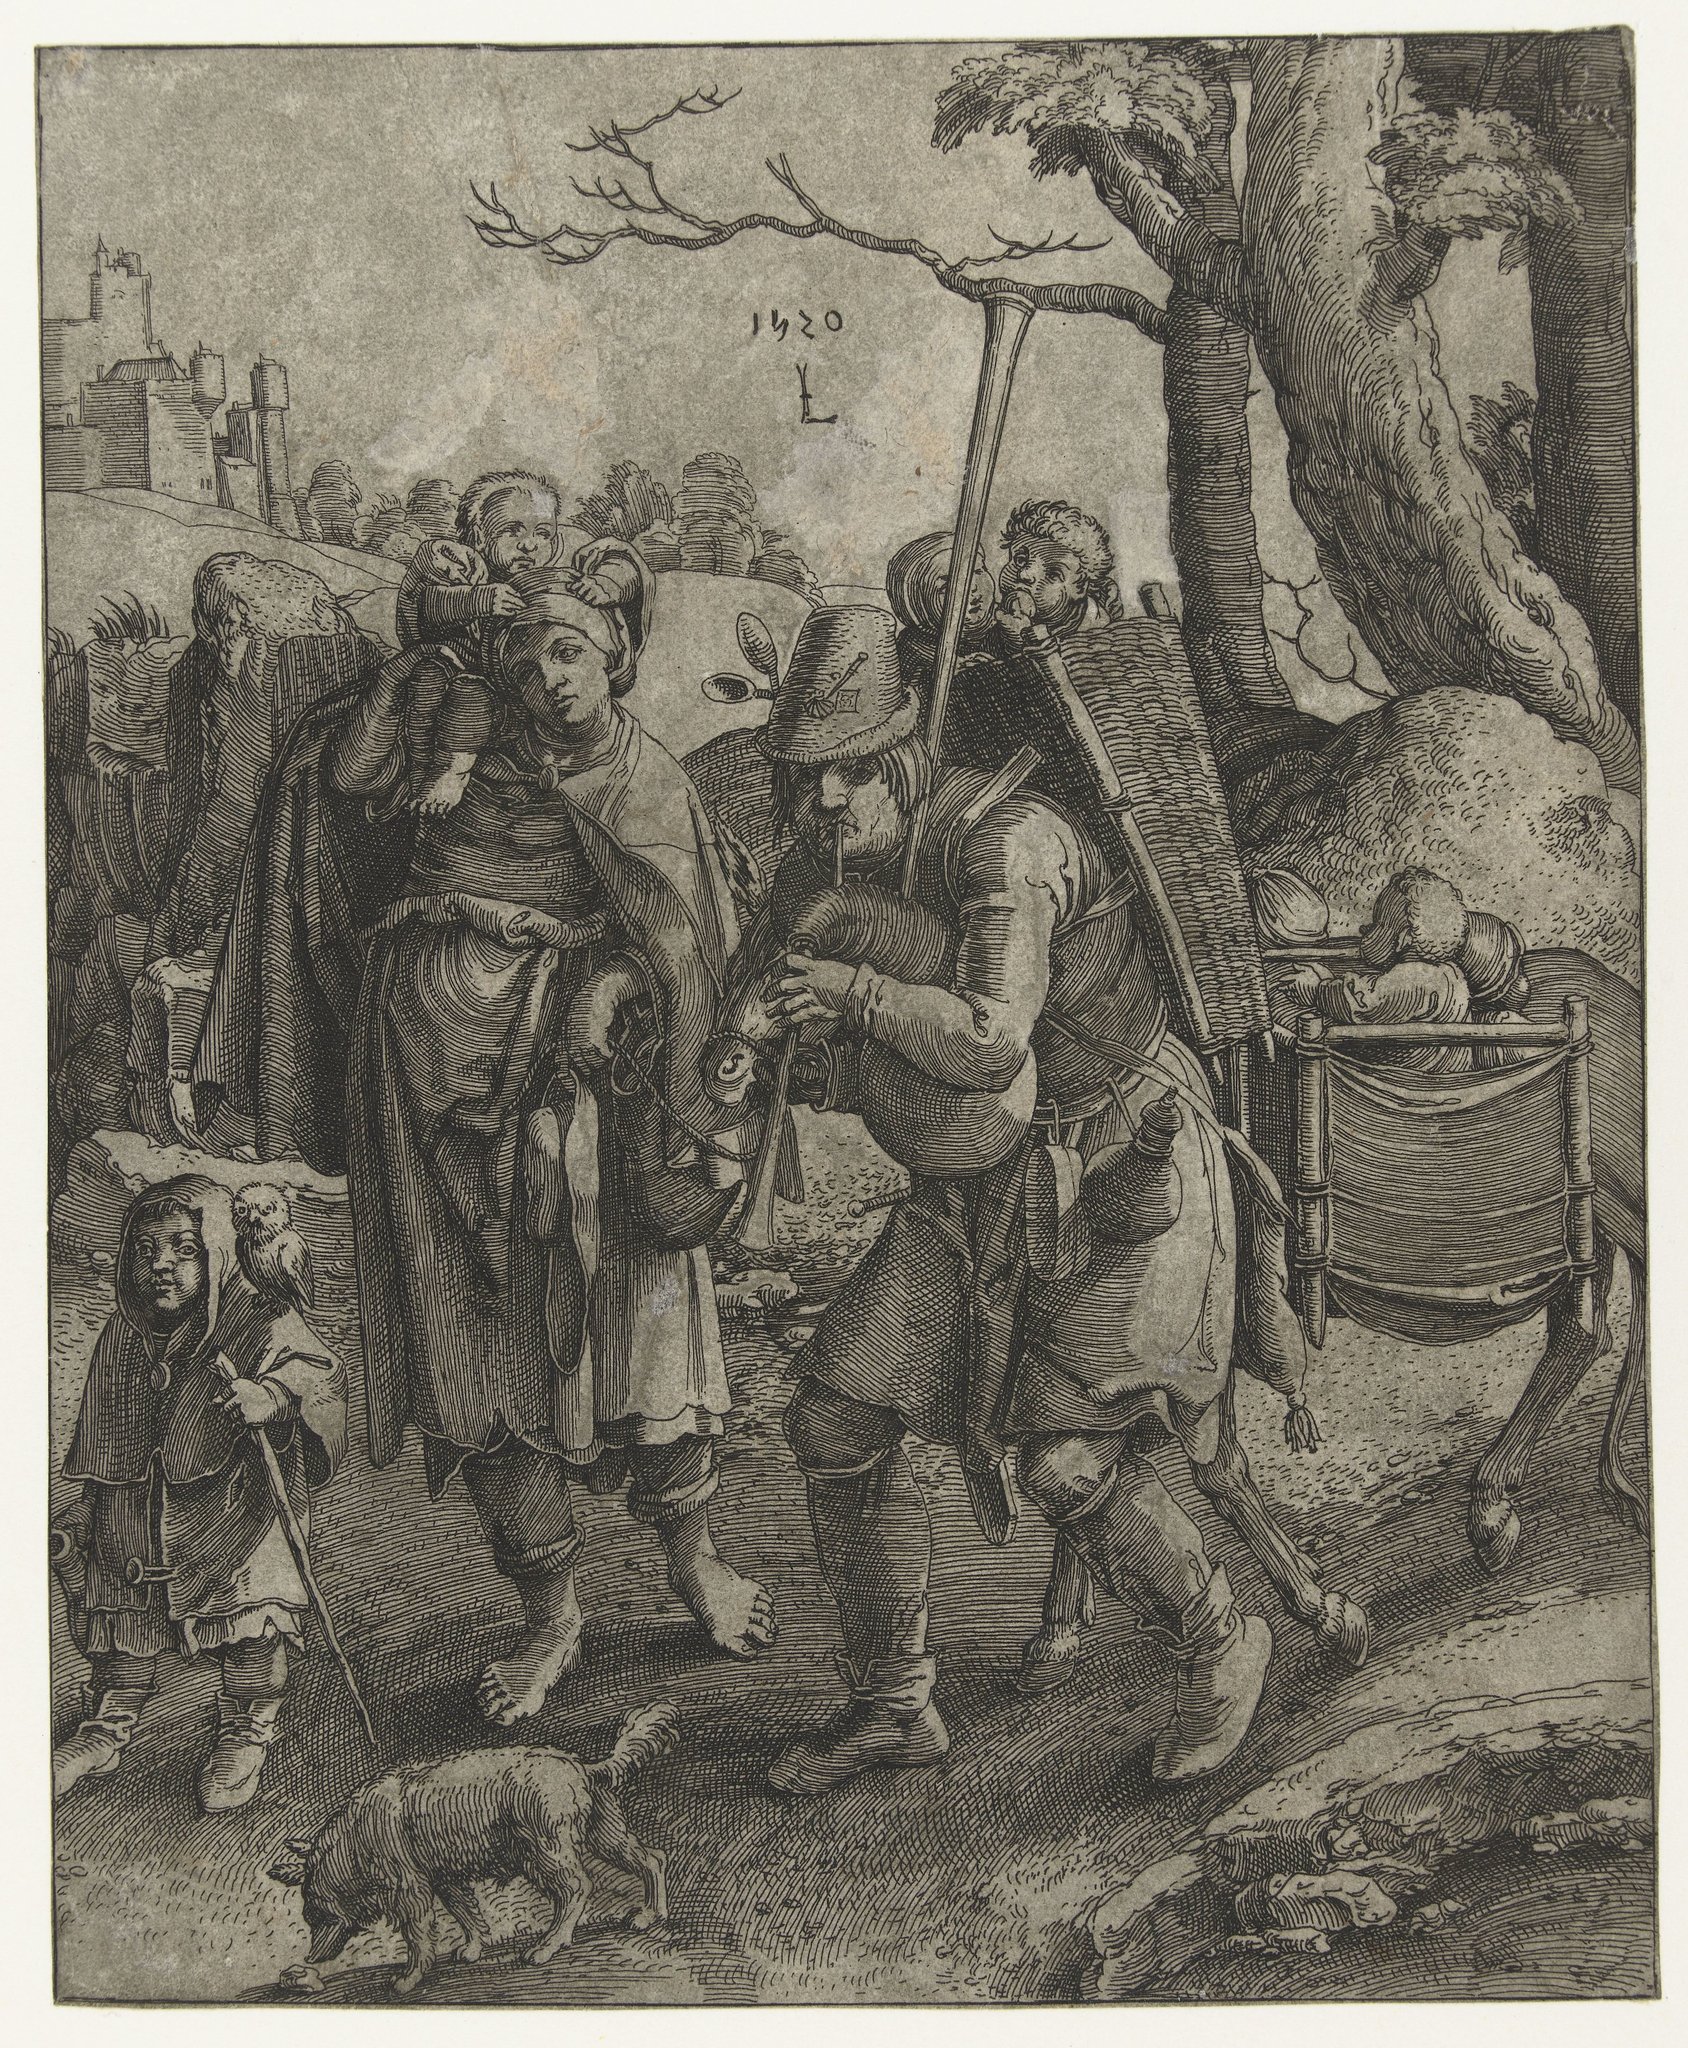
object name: print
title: Uilenspiegel: de bedelaarsfamilie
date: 1520-1583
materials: paper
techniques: etching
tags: one person playing wind instrument, bagpipe, musette, carrying something in basket, bag, rucksack, etc., 'fahrende leute', vagrants, eulenspiegel, beggar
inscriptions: collector's mark: Lugt 240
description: Doedelzakspelende man met twee kinderen in de mand op zijn rug, naast hem een vrouw met een kind op de schouder. Zij voeren een ezel mee, beladen met kinderen. Voorop loopt een jongen met een uil op de schouder, naast hem snuffelt een hondje.